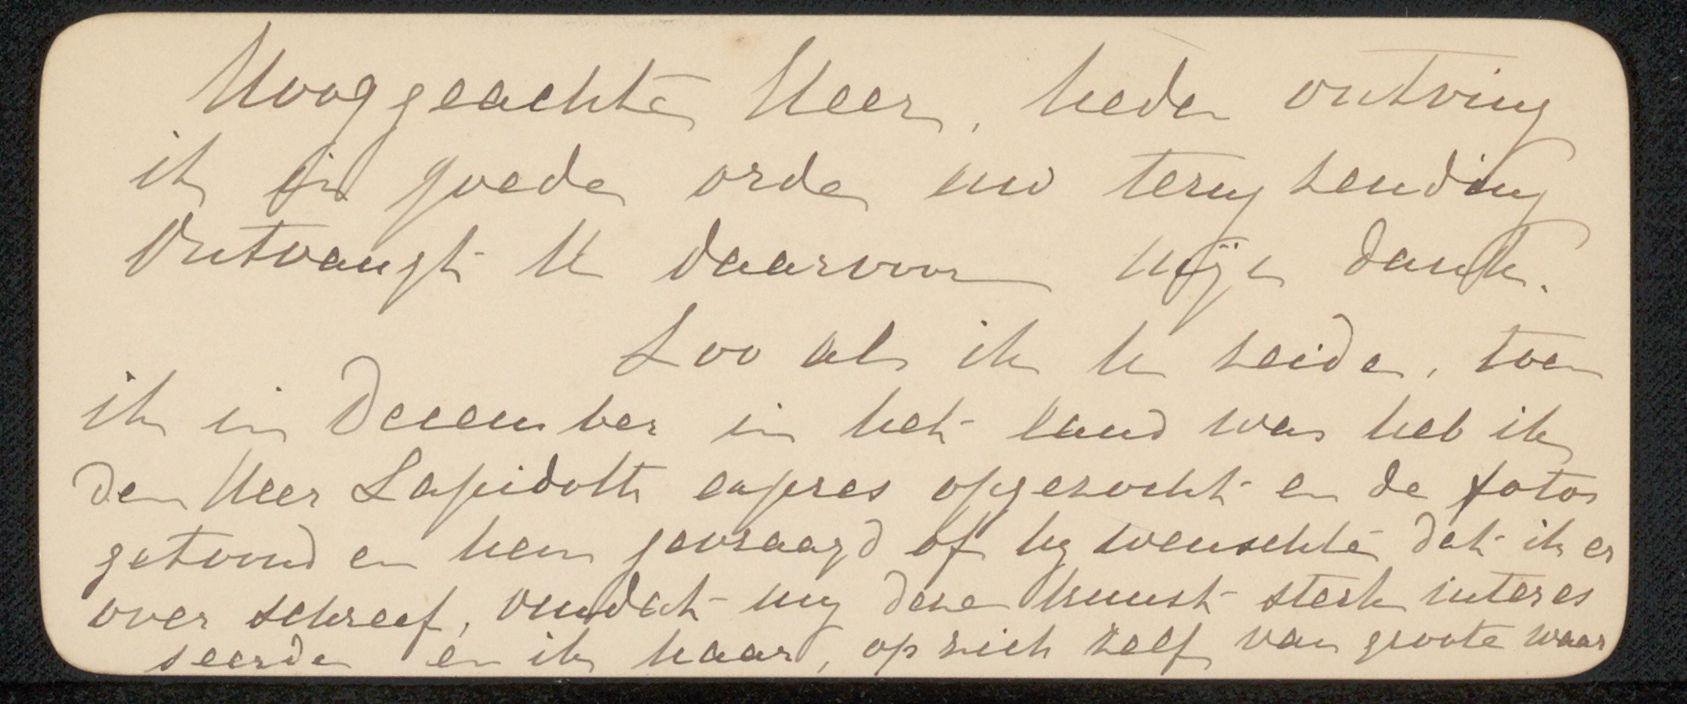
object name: letter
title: Brief aan Philip Zilcken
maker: jonkvrouw cécile de jong van beek en donk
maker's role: schrijver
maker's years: 1866-1944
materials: cardboard, ink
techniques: pen, writing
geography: paris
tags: draughtsman, sculptor, antoine bourdelle, frits lapidoth, painter, philip zilcken, photography, cinematography, sculpture, printed matter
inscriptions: collector's mark: ‘RPK’